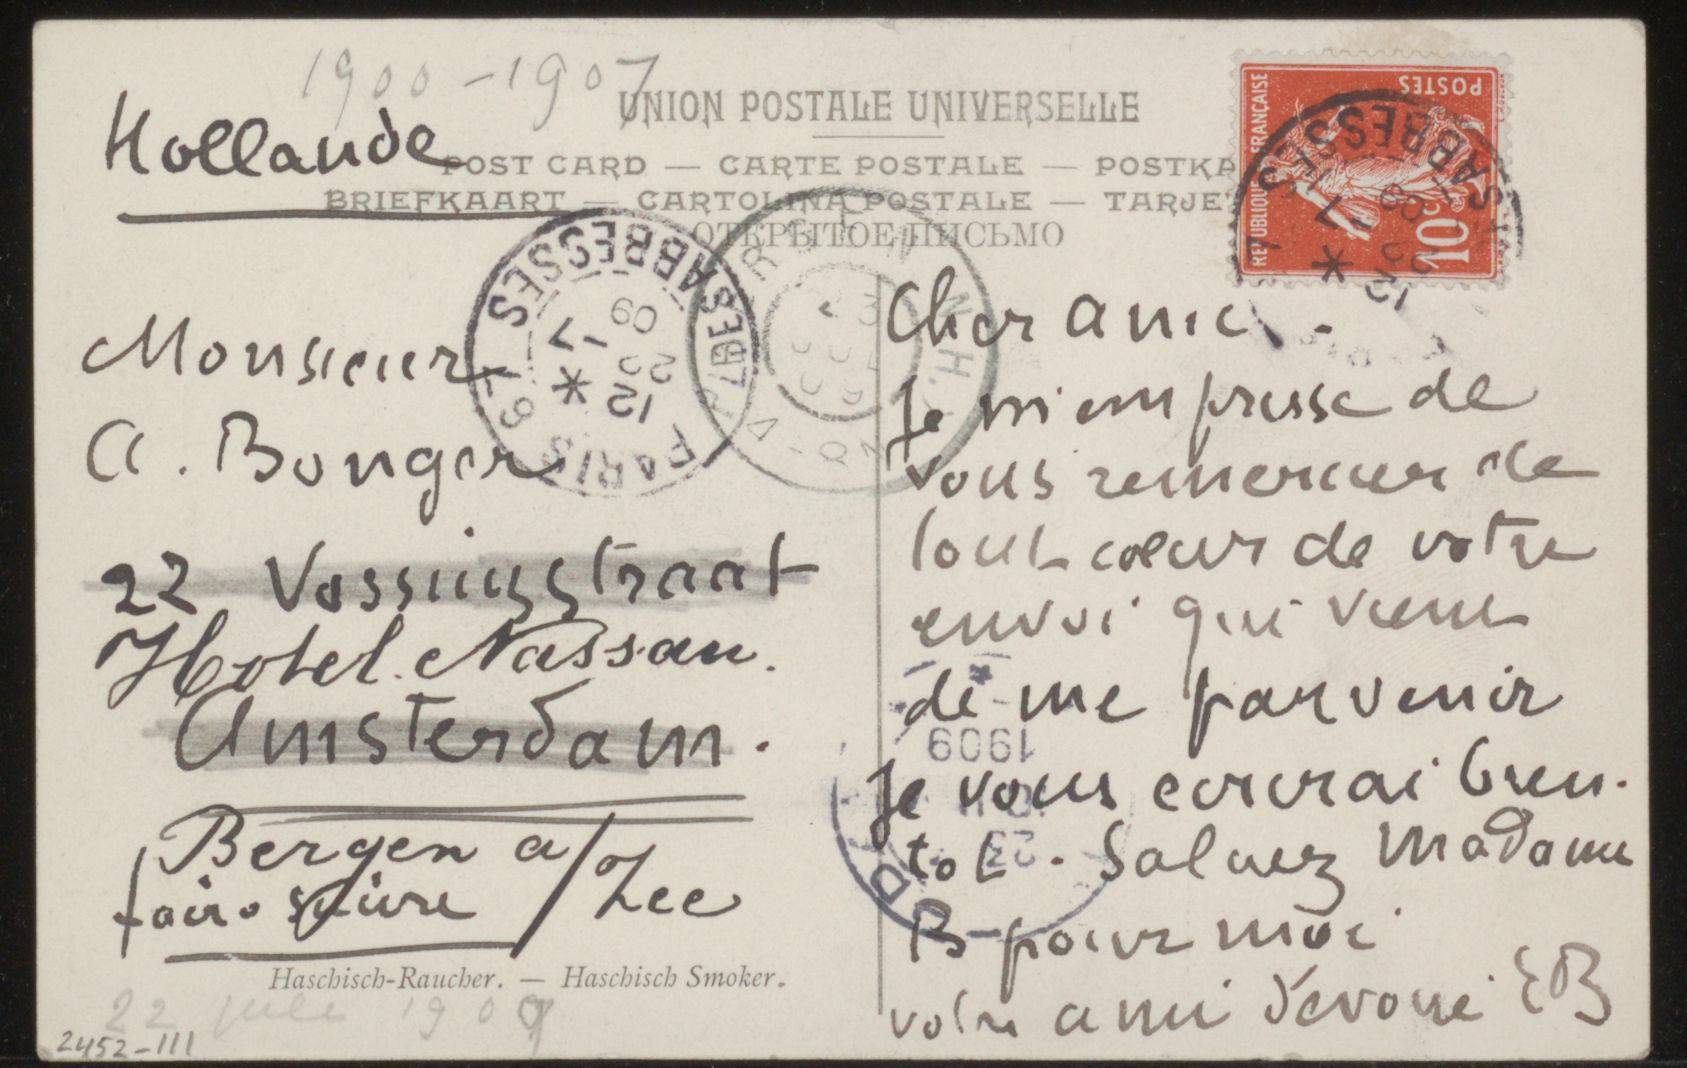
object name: ansichtkaart, prentbriefkaart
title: Prentbriefkaart aan Andries Bonger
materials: cardboard, ink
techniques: photograph, pen, writing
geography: paris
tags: andries bonger